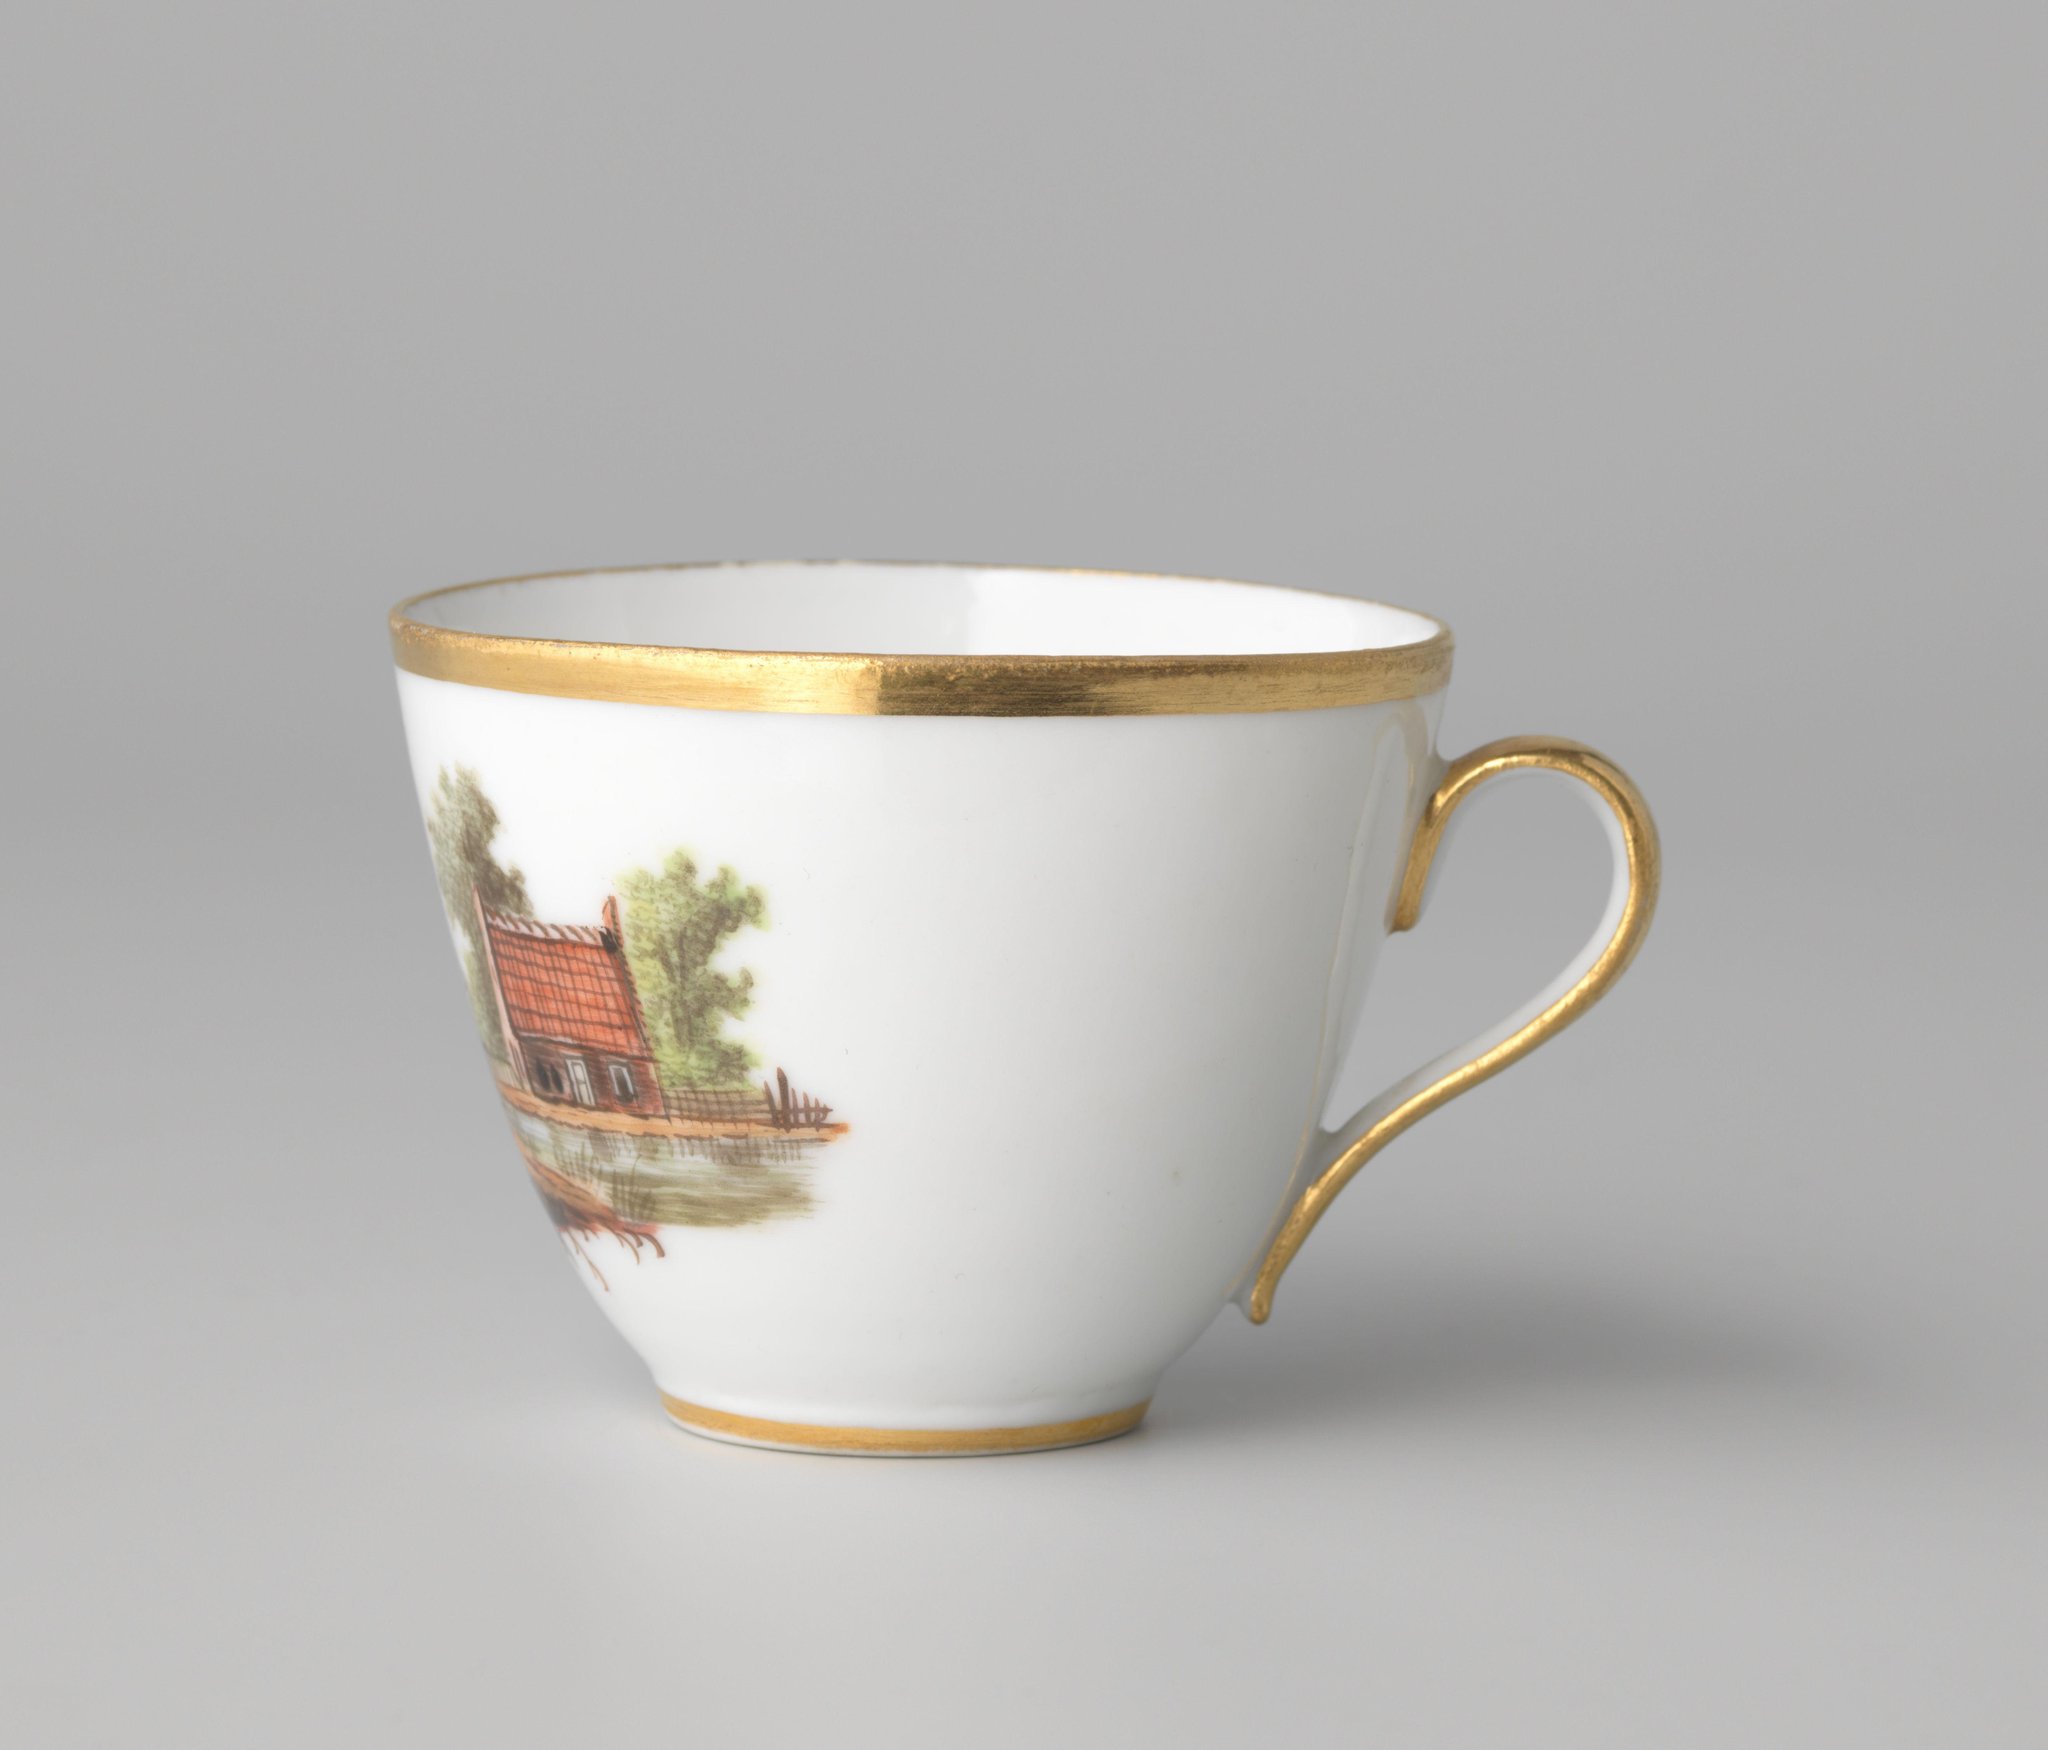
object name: kop en schotel, kop en schotel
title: Kop met riviergezicht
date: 1809-1814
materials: porcelain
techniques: painted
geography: nieuwer-amstel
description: Kop versierd met een veelkleurig landschap. Een zittende en staande man en boerderij langs de rievier. Langs de randen en het oor een een gouden rand. Gemerkt: Amstel.